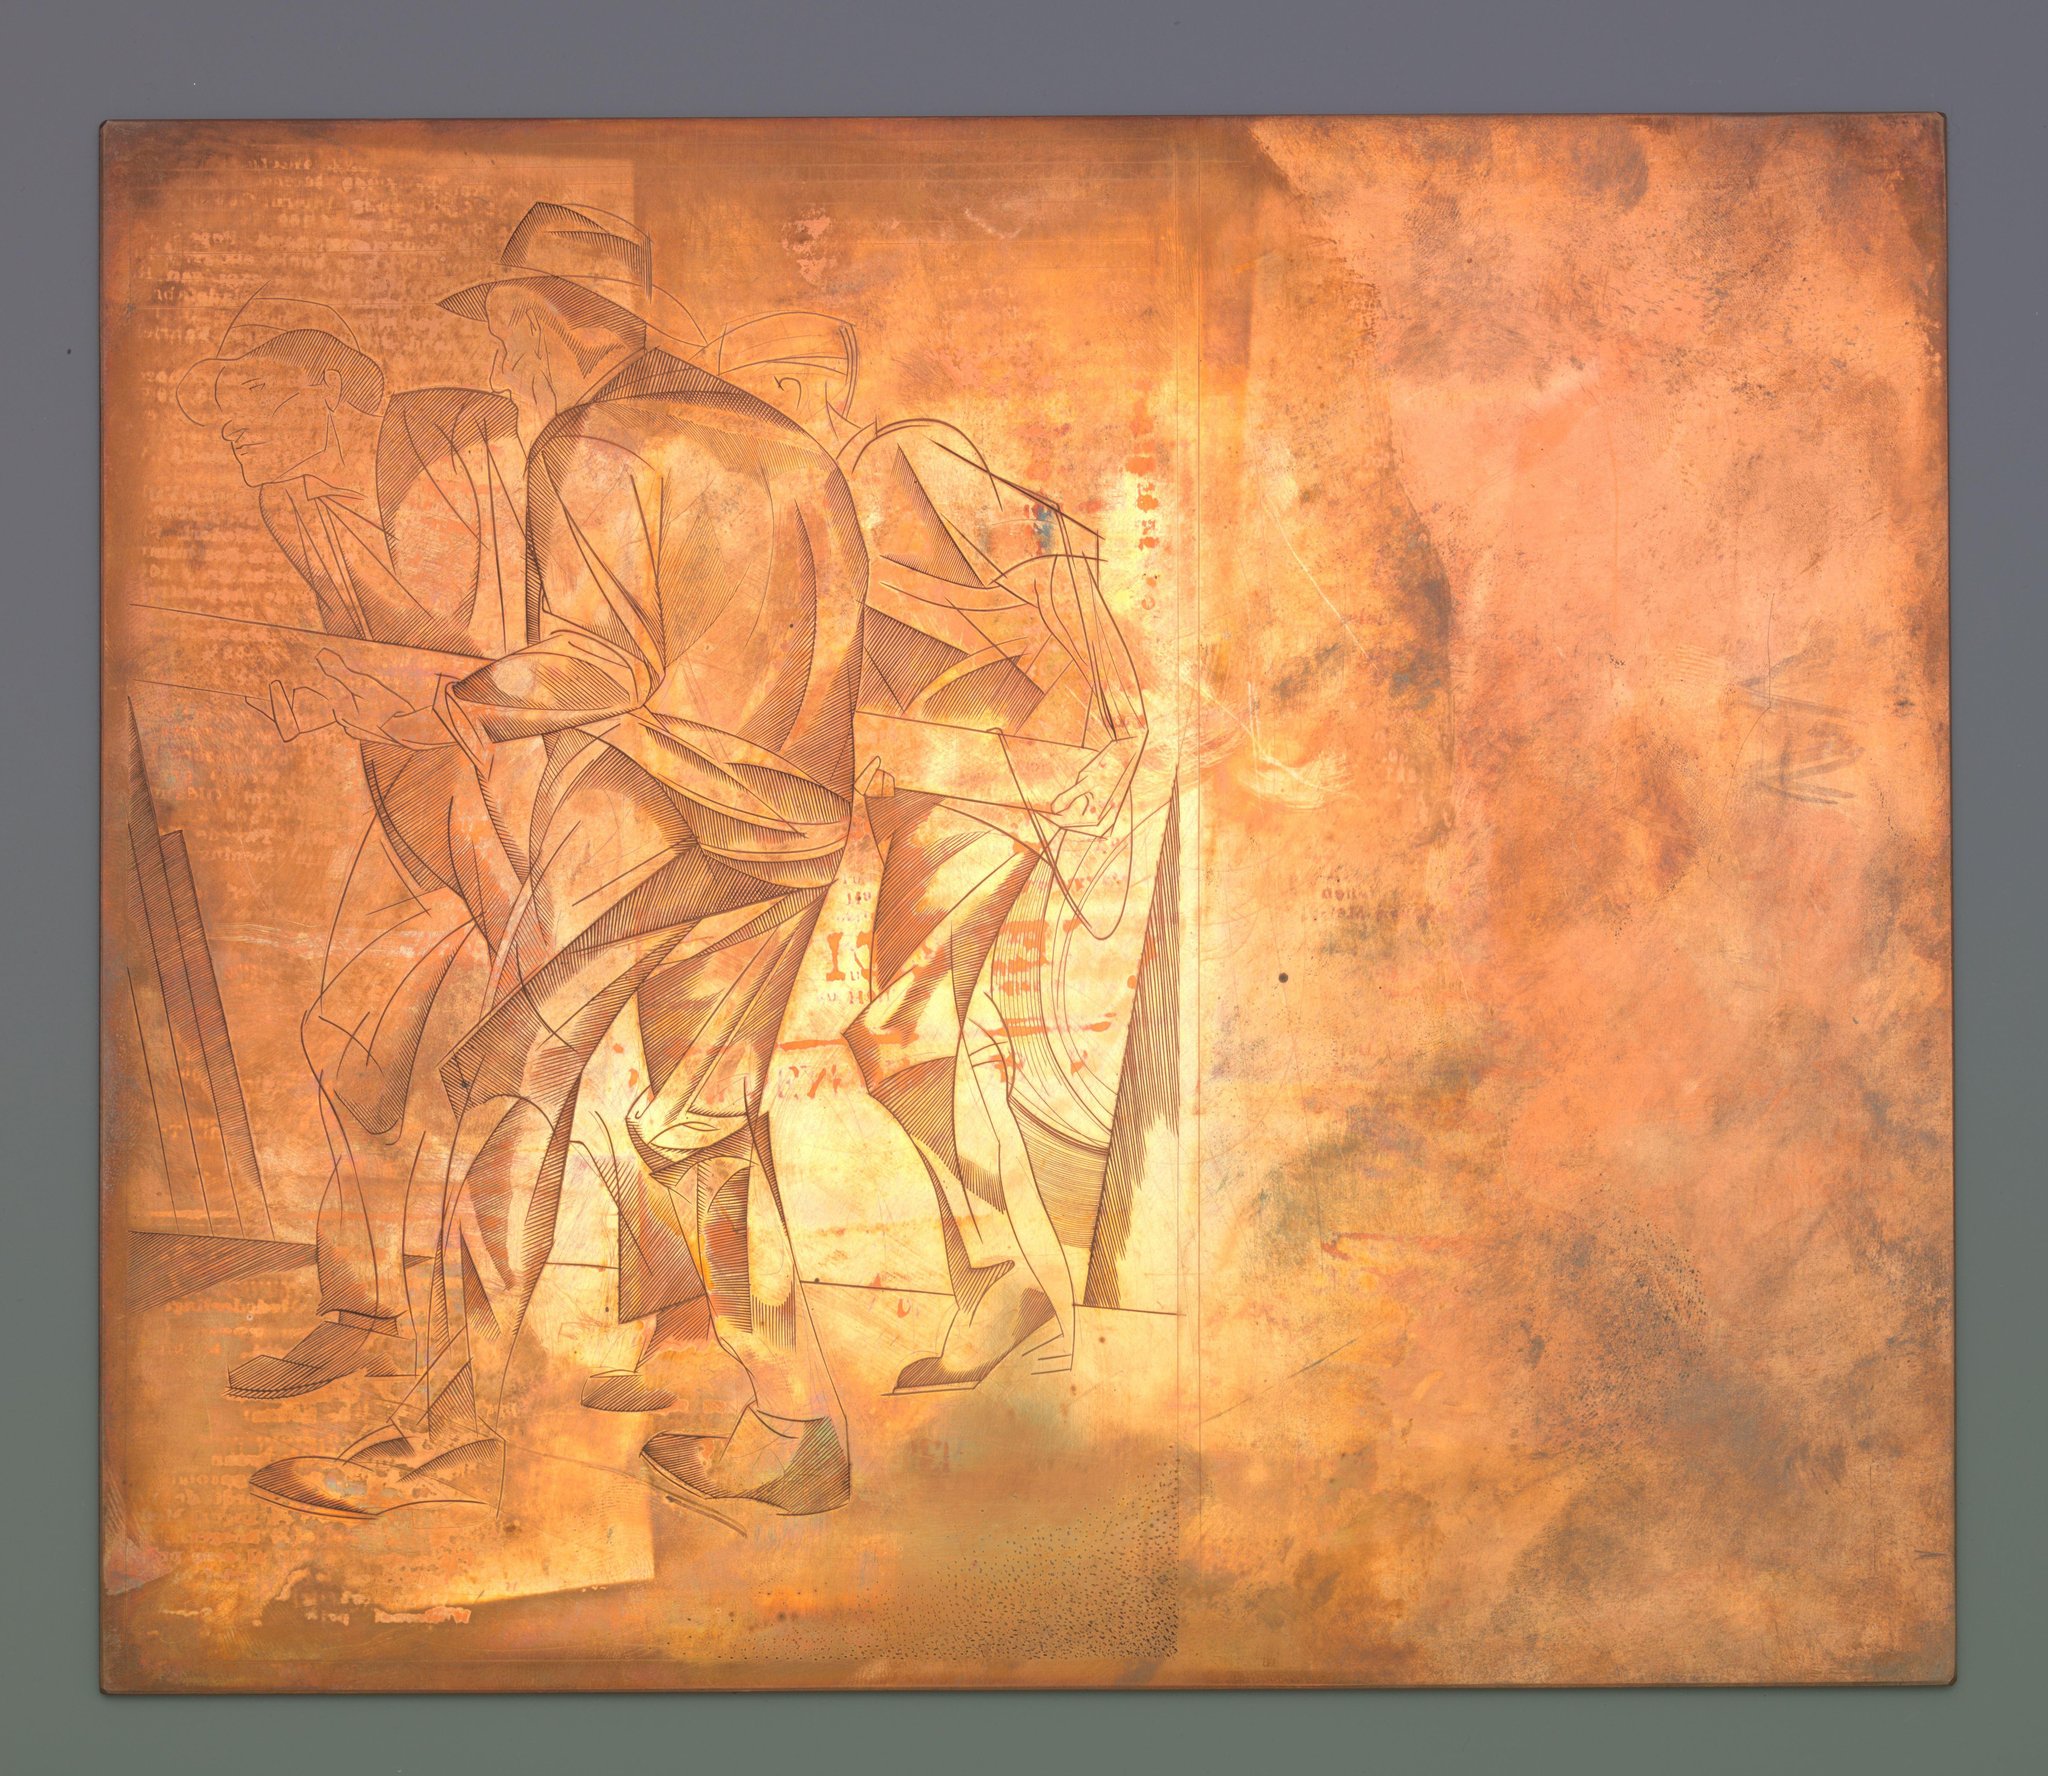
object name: copper plate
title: Drie mannen dragen een balk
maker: johannes josephus aarts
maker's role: draughtsman, print maker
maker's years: 1871-1934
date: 1881-1934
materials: copper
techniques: engraving